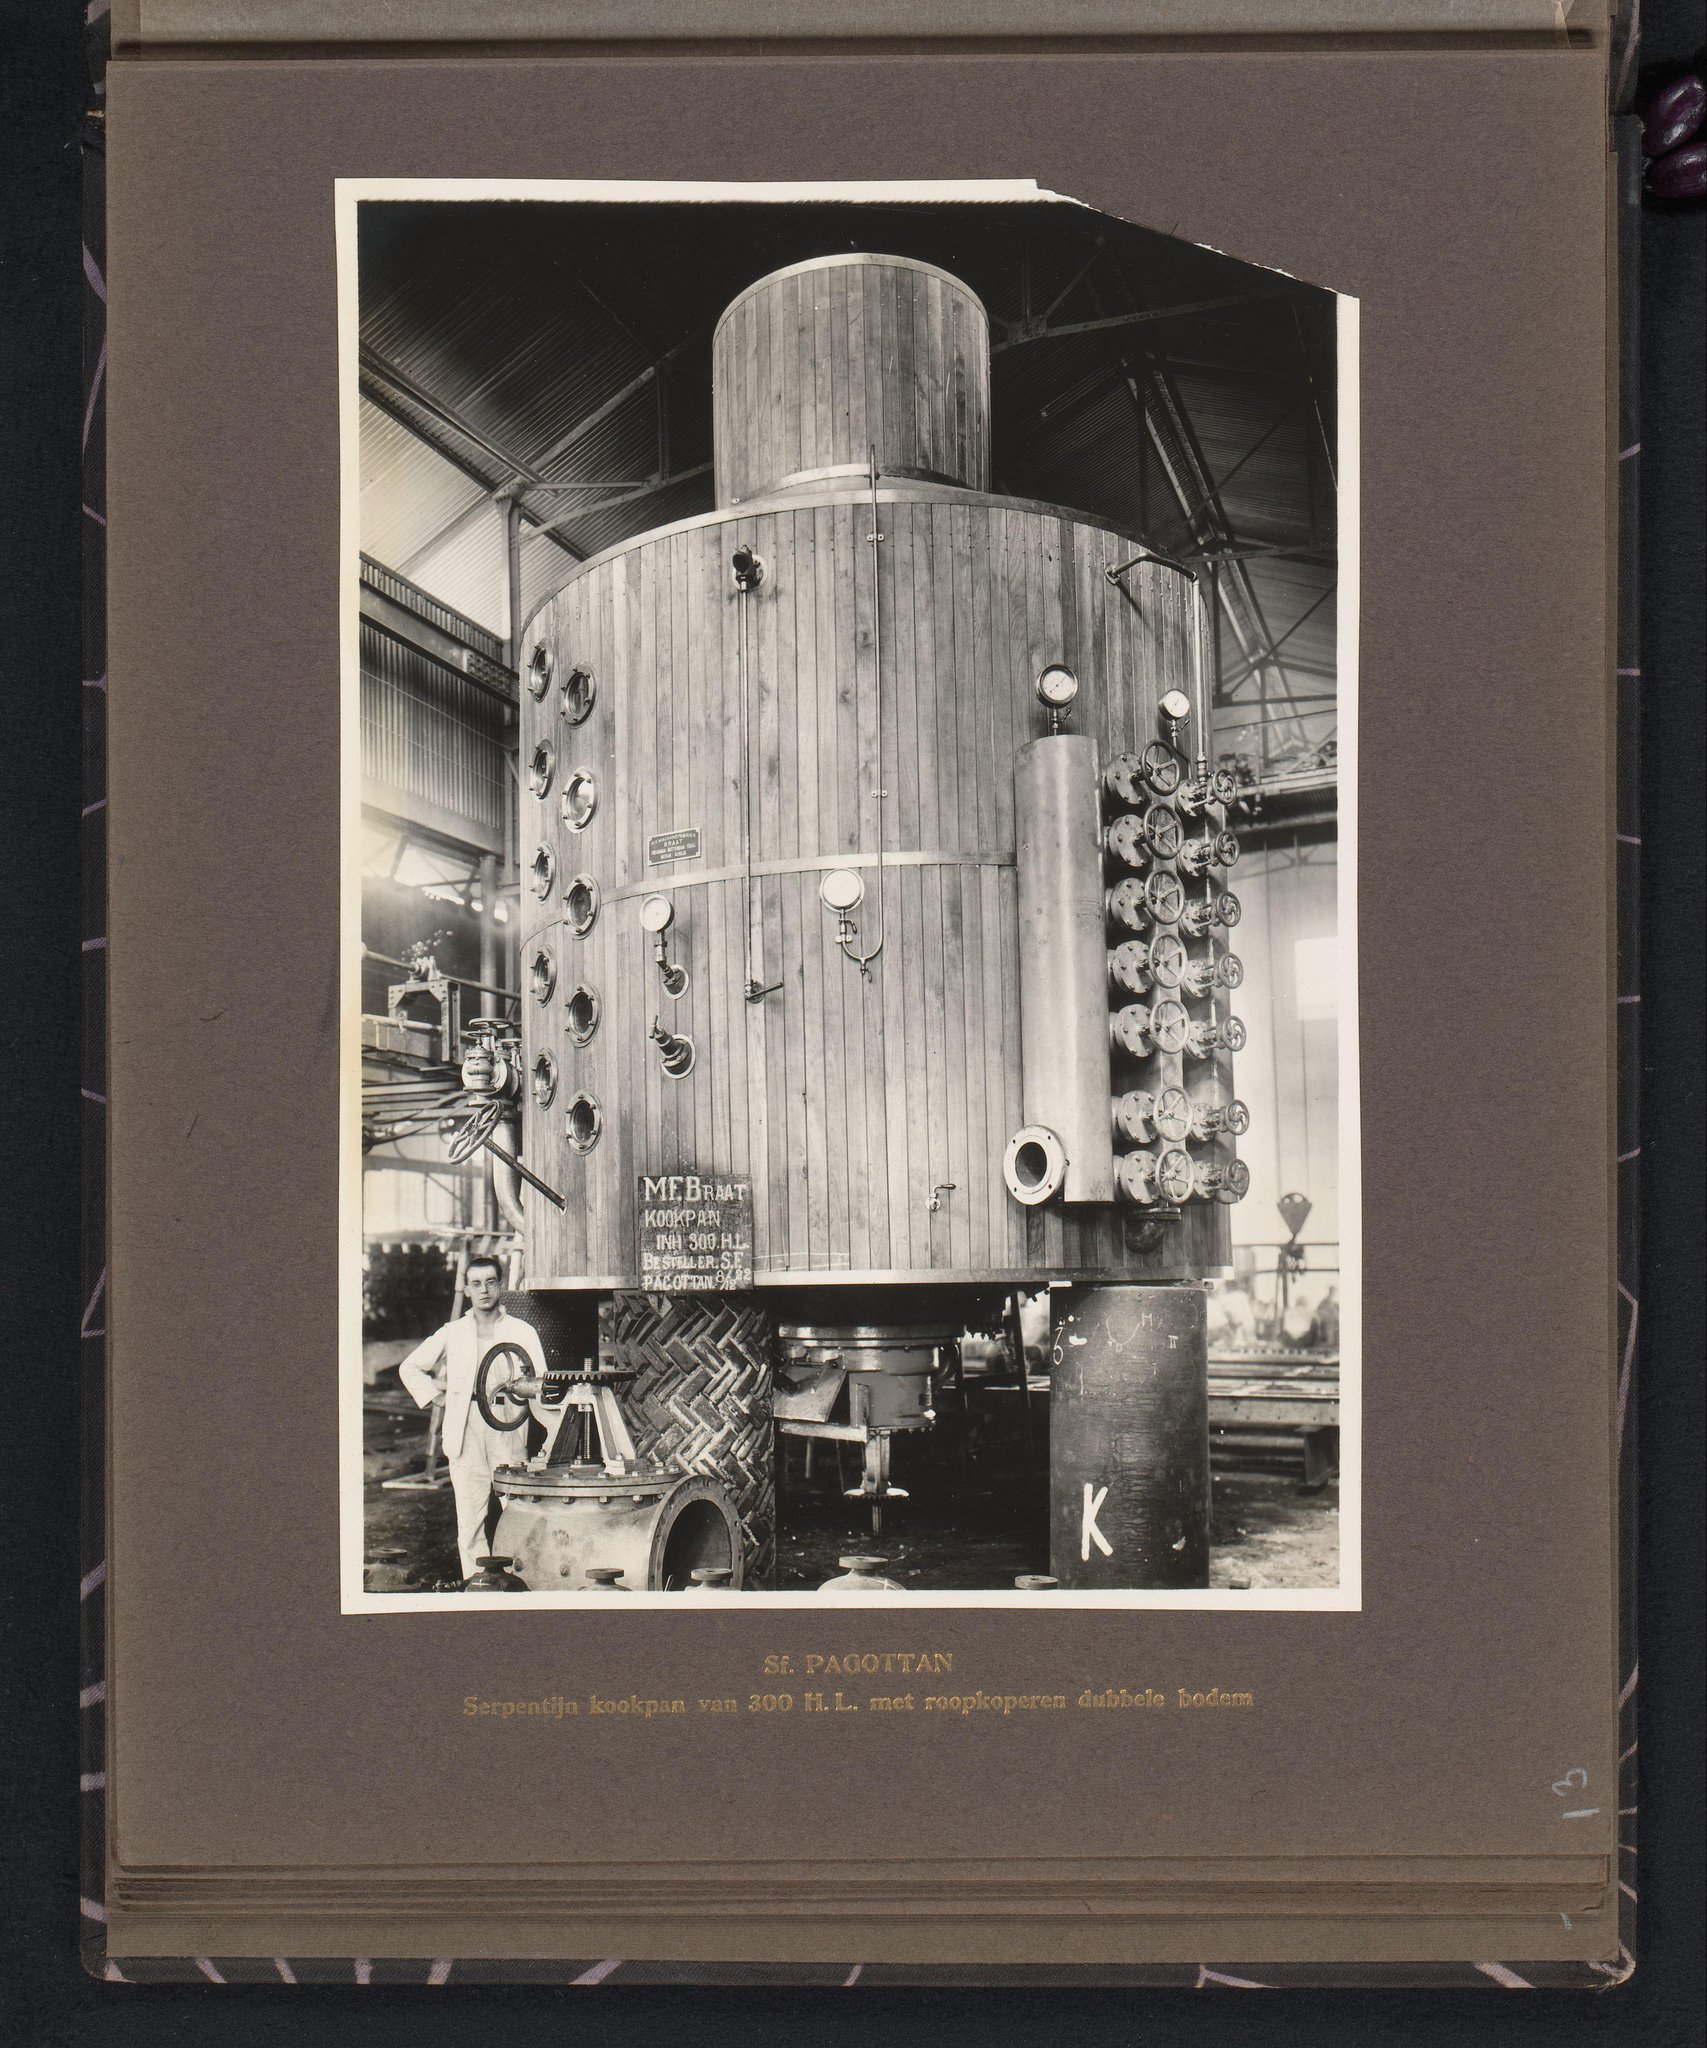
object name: album leaf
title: Sf. Pagottan Serpentijn kookpan van 300 H.L. met roodkoperen dubbele bodem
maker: Anonymous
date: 1922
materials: cardboard, photographic support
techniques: gelatin silver print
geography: surabaya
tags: colonial system, factory-interior, machine shop, machines; parts of machines; tools and appliances, director, boss (in modern industry), java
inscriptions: date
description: Albumblad met een foto van een ketel. Vervaardigd door Machinefabriek Braat en bestemd voor de Suikerfabriek Pagottan, 8 december 1922. Onderdeel van het fotoalbum Machinefabriek Braat Soerabaia-Djocja-Tegal, ca. 1916-1924.